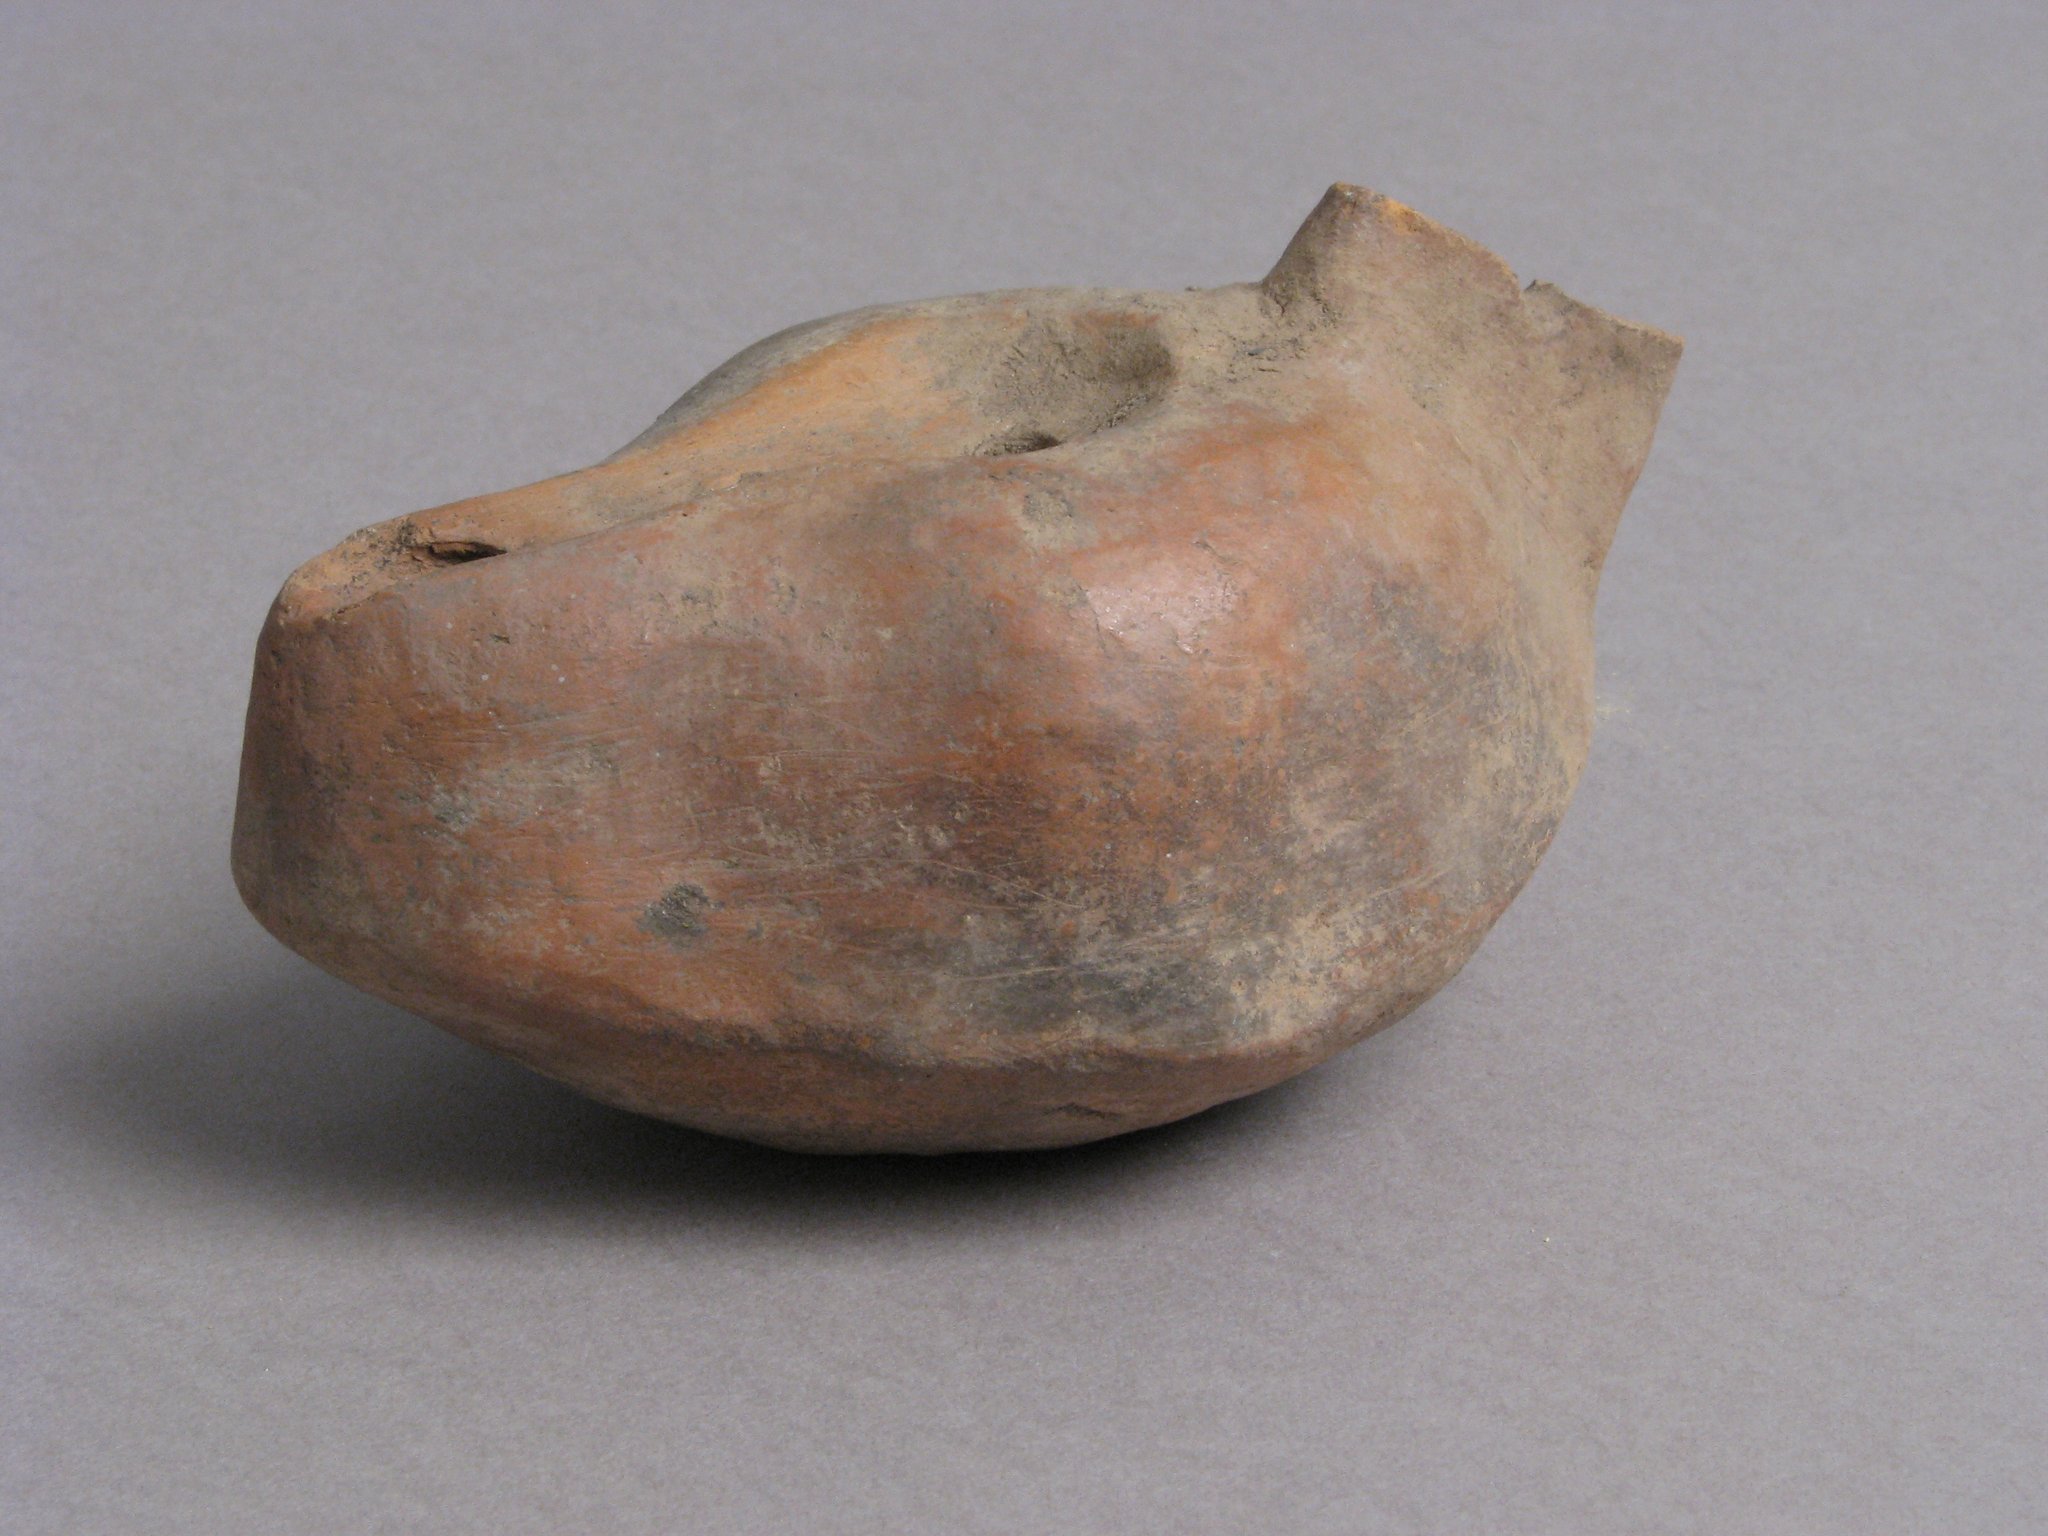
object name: lamp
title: Oil Lamp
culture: coptic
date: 301-700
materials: earthenware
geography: egypt